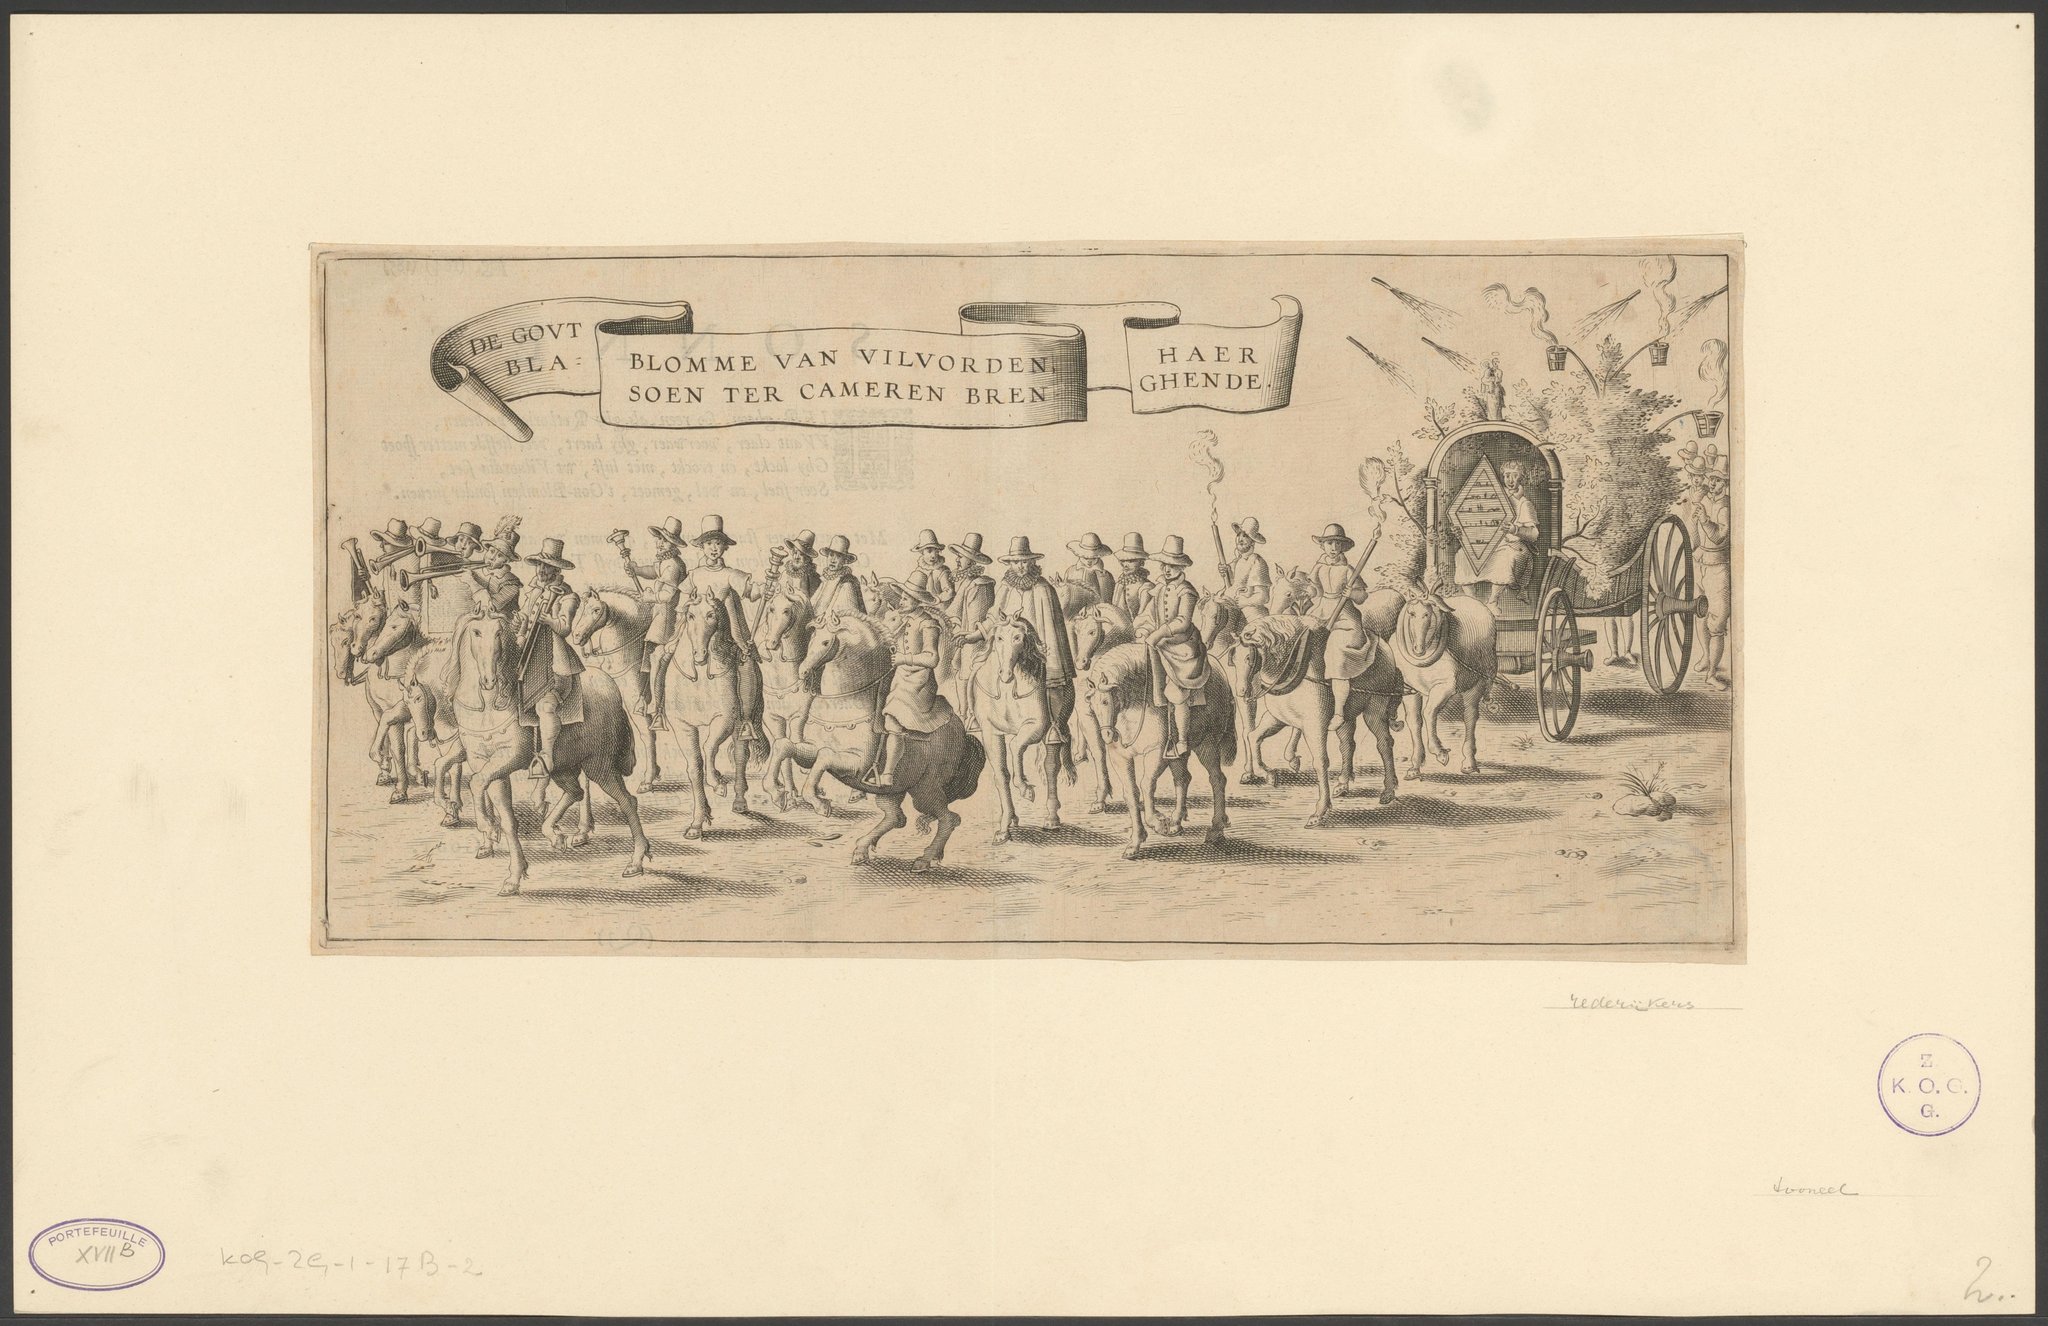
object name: print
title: Rederijkers van de kamer Gout-Blomme van Vilvoorde tonen hun blazoen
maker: Anonymous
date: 1620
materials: paper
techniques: engraving, etching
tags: 'rhetorica', 'eloquentia' (~ trivium); 'rettorica' (ripa), chamber of rhetoric (dutch: 'rederijkerskamer')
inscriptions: collector's mark: Lugt 1641, stamp:, stamp: Lugt 1641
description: Rederijkers van de kamer Gout-Blomme van Vilvoorde dragen hun blazoen op een wagen tijdens een optocht. Op verso een sonnet van de Rederijkerskamer. Onderwerpsrubrieken binnen de Atlas Zeden en Gewoonten: Schoone kunsten, Tooneel, Rederijkers.